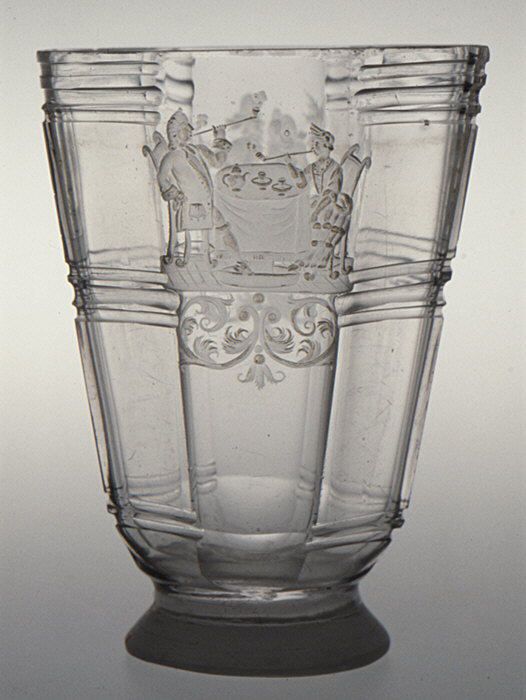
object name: water glass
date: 1720-1730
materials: glass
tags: smoking,drinking